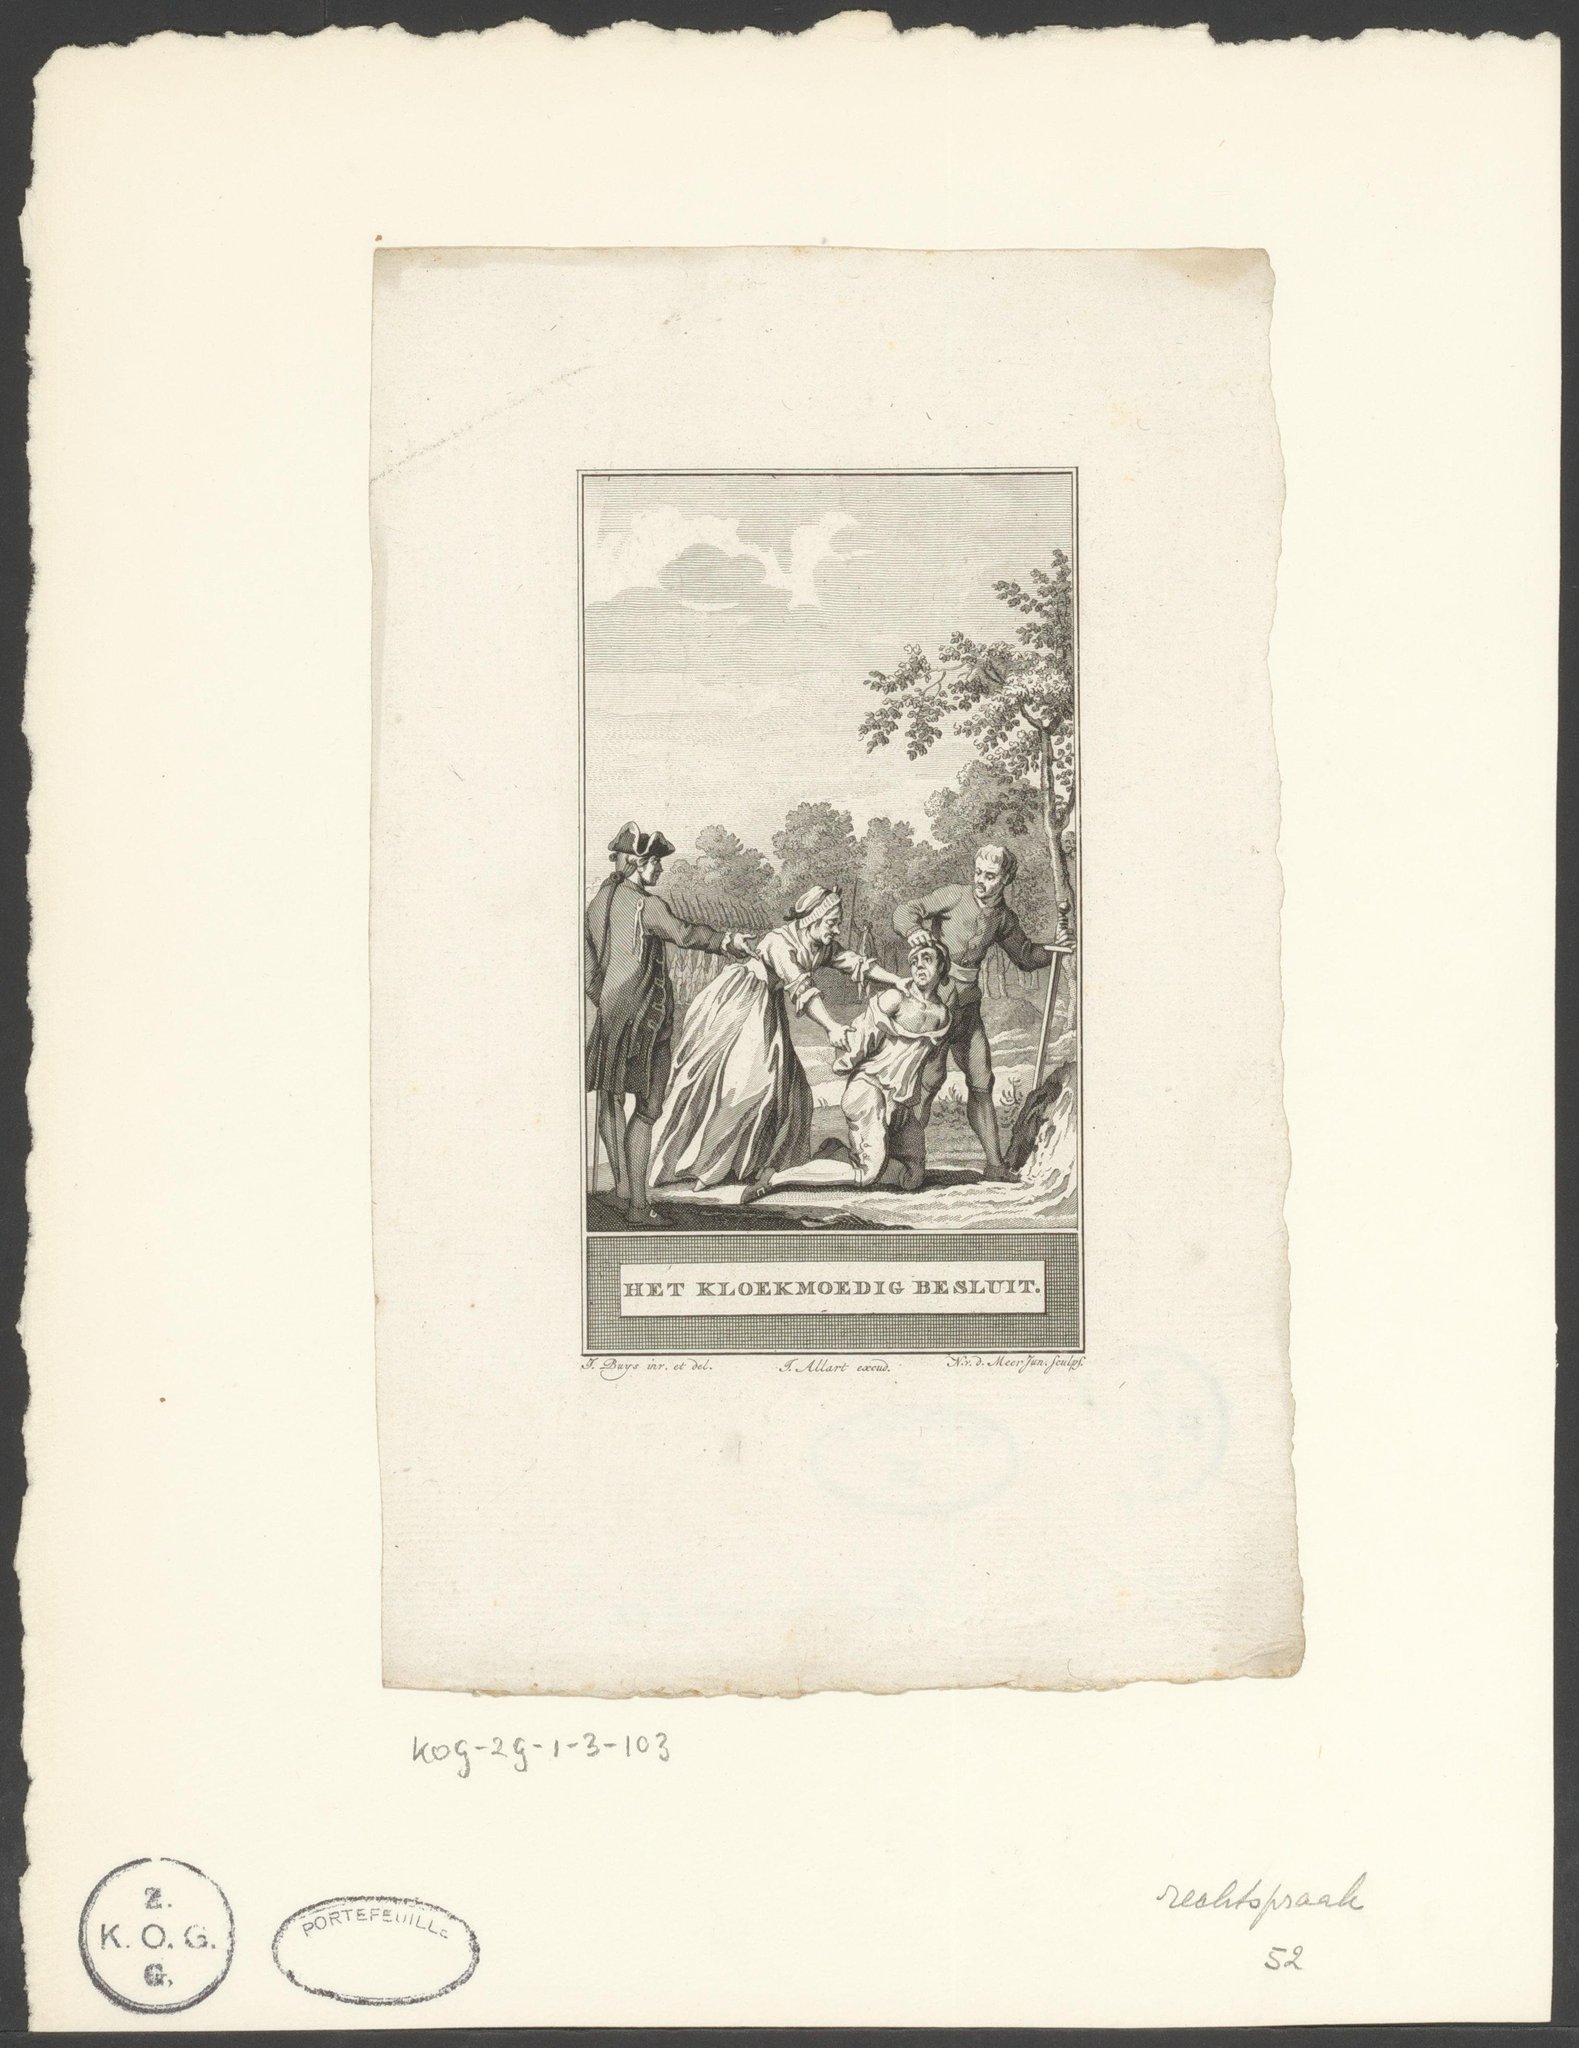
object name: print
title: Het kloekmoedig besluit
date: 1778-1785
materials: paper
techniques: engraving, etching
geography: amsterdam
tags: last hours before execution, hacking and thrusting weapons: sword, ugly old woman, hag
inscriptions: stamp, stamp:, collector's mark: Lugt 1641, collector's mark: Lugt 1641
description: Prent bij: Gellert, Christian Fürchtegott. Fabelen en vertelsels. 3 dln. Amsterdam: Pieter Meyer, 1772-1774. De prenten bij deze publicatie werden later uitgegeven. De exemplaren uitgegeven door de weduwe Jacobus Loveringh & Johannes Allart tussen 1777 en 1778, de exemplaren uitgegeven door alleen Johannes Allart tussen 1778 en 1785.